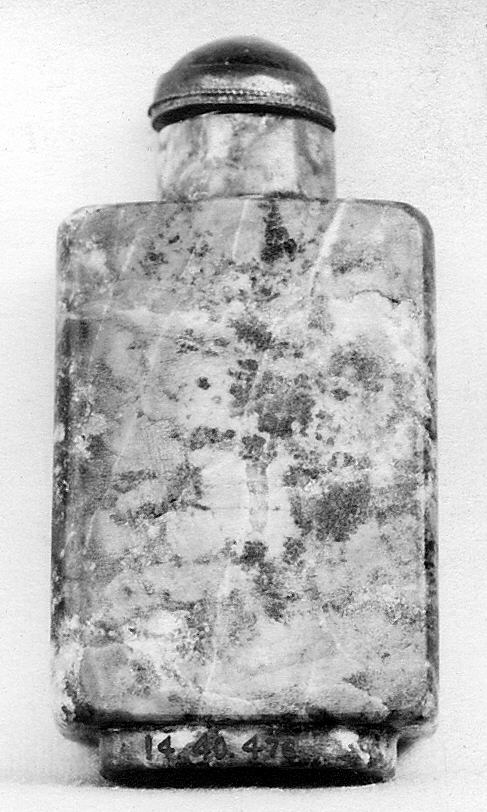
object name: snuff bottle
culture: chinese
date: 1801-1900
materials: glass, lapis lazuli